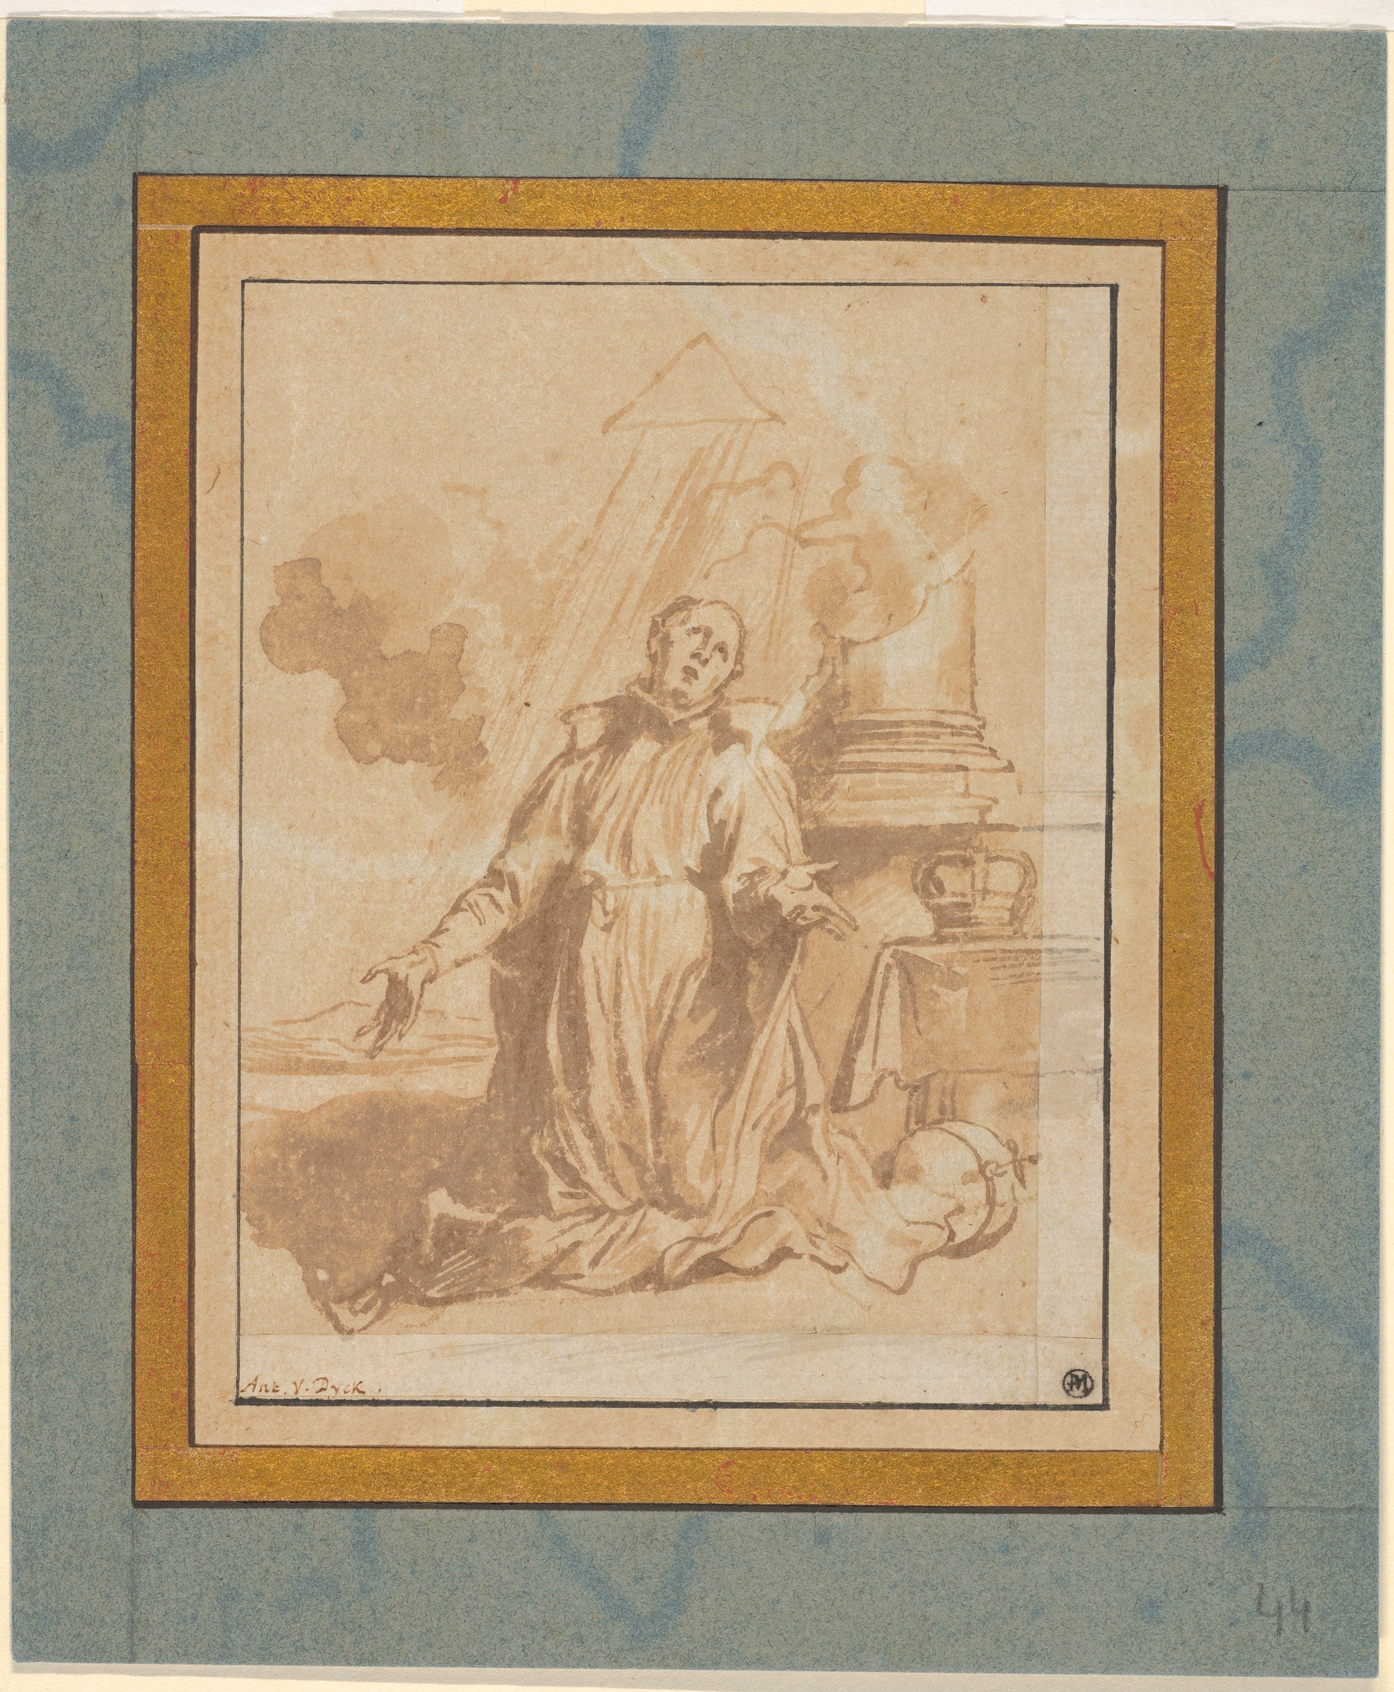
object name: drawing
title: The Blessed Aloysius Gonzaga in Ecstasy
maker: anthony van dyck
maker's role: artist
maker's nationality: flemish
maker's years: 1599-1641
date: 1629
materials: ink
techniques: brush, pen, wash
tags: saints